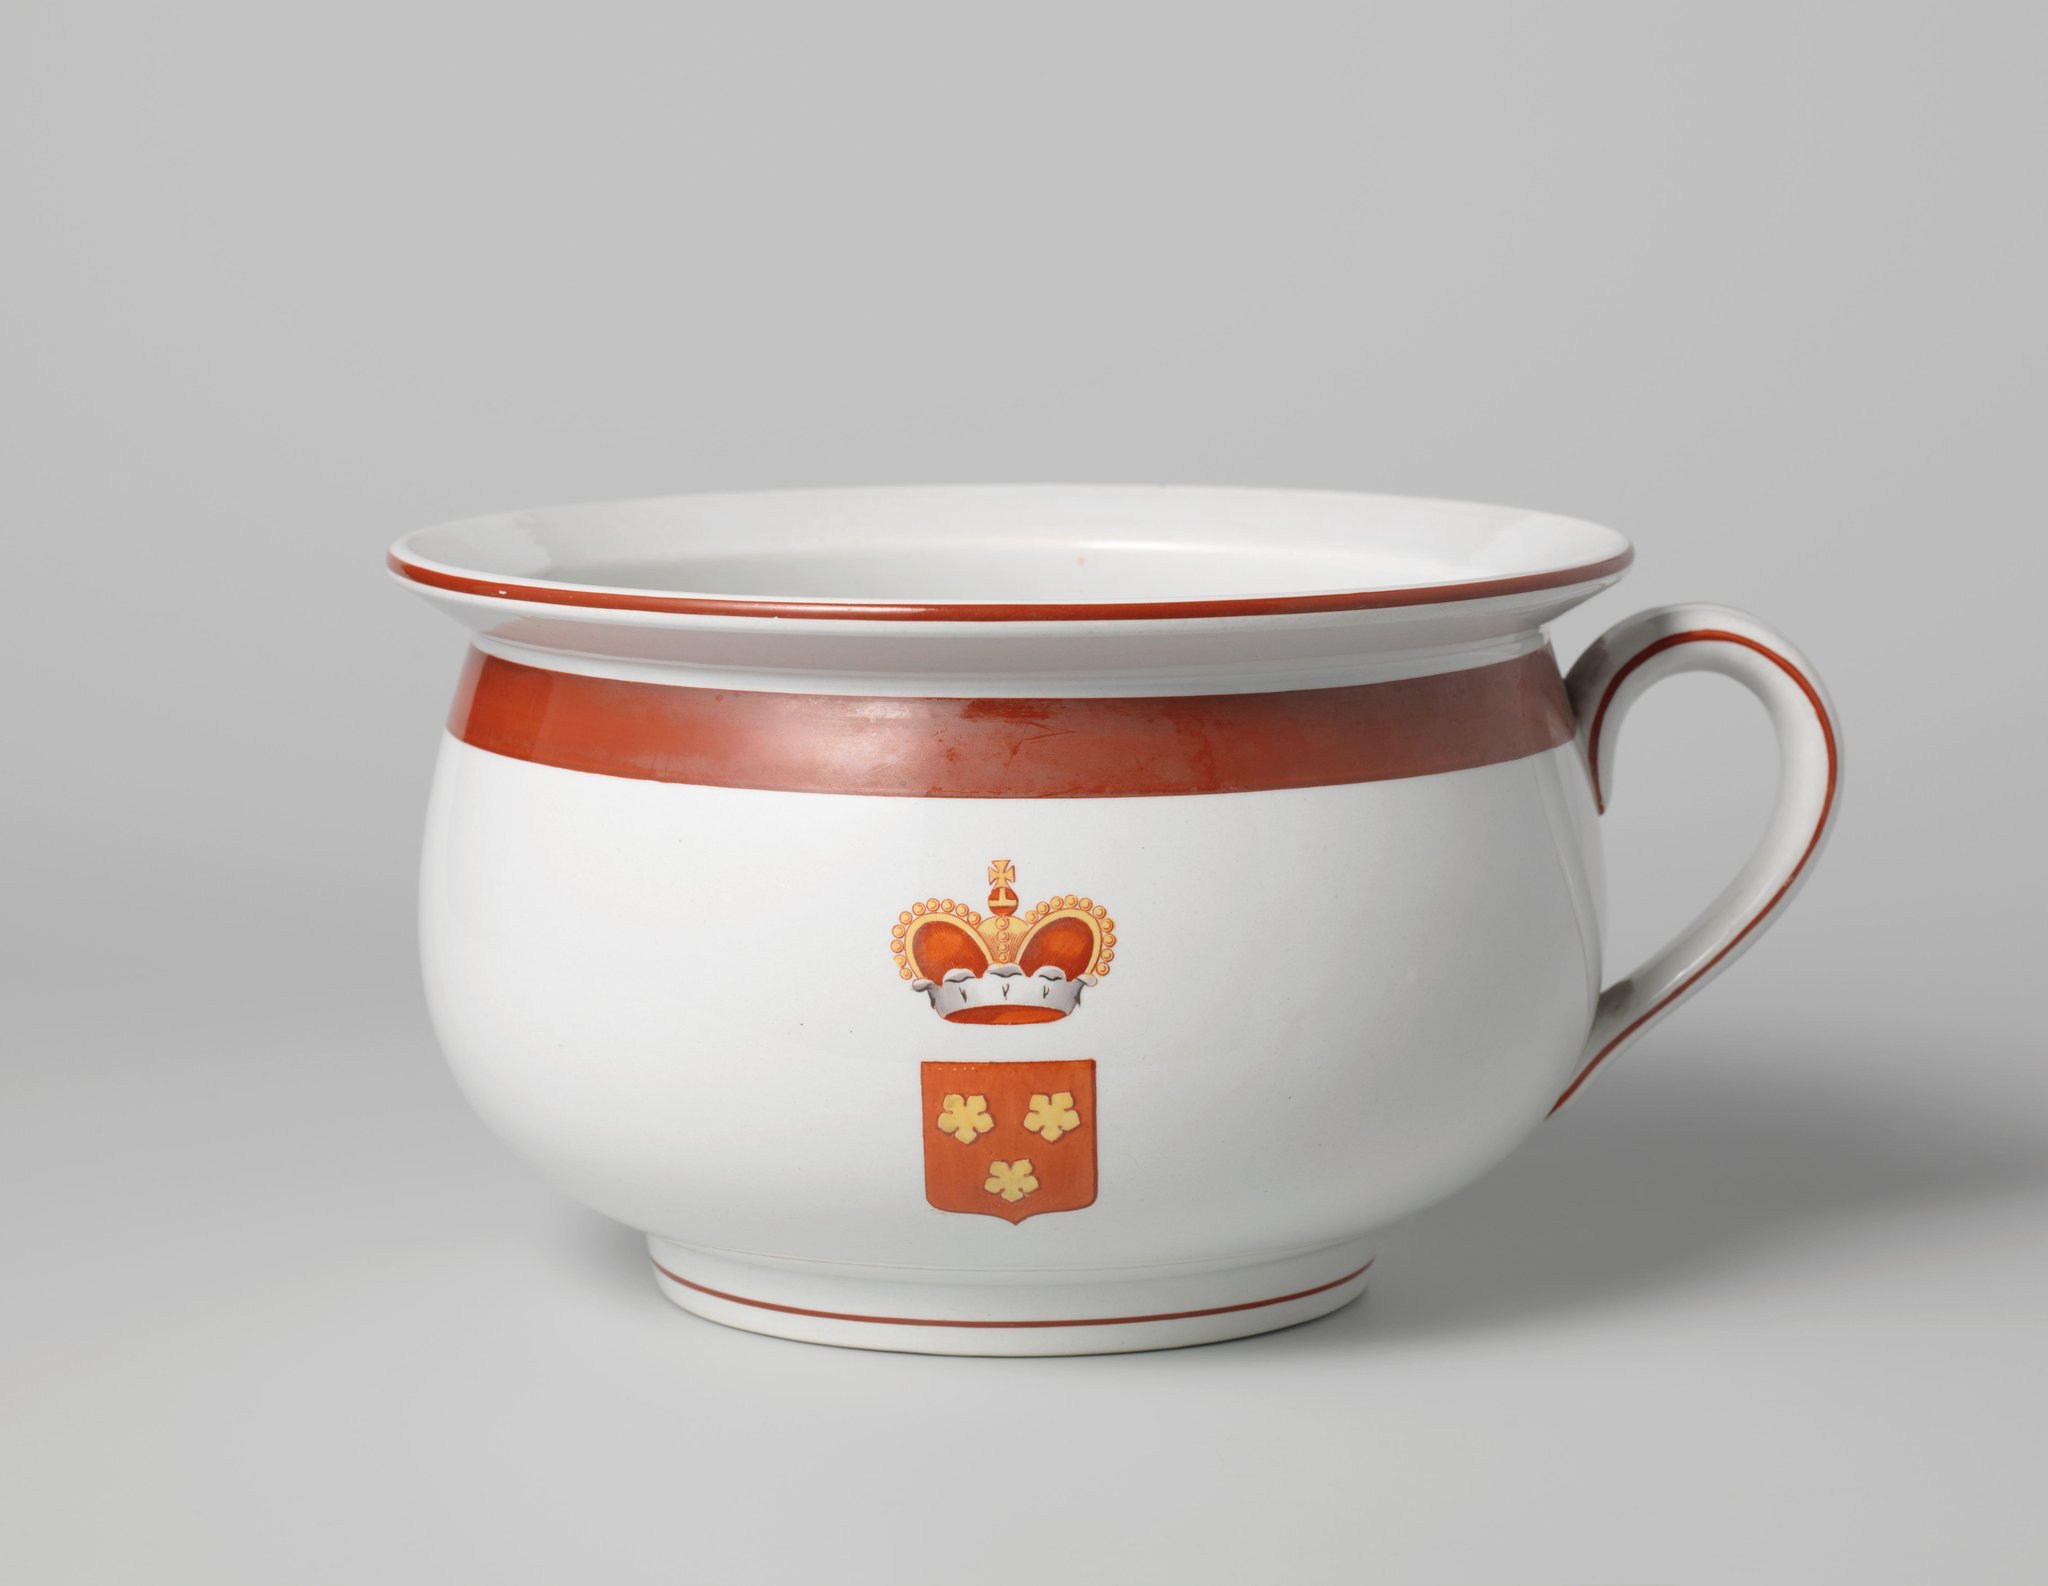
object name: chamber pot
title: Kamerpot, deel van een toiletgarnituur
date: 1874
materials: earthenware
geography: wallerfangen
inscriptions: mark: ‘wapen waaromheen China Sarreguemines; P1 en 9 (beide ingegrift)’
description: Kamerpot met oor, deel van een toiletgarnituur van aardewerk. Versierd met rode biezen en het wapen van de Hertog van Arenberg met kroon in rood en geel.